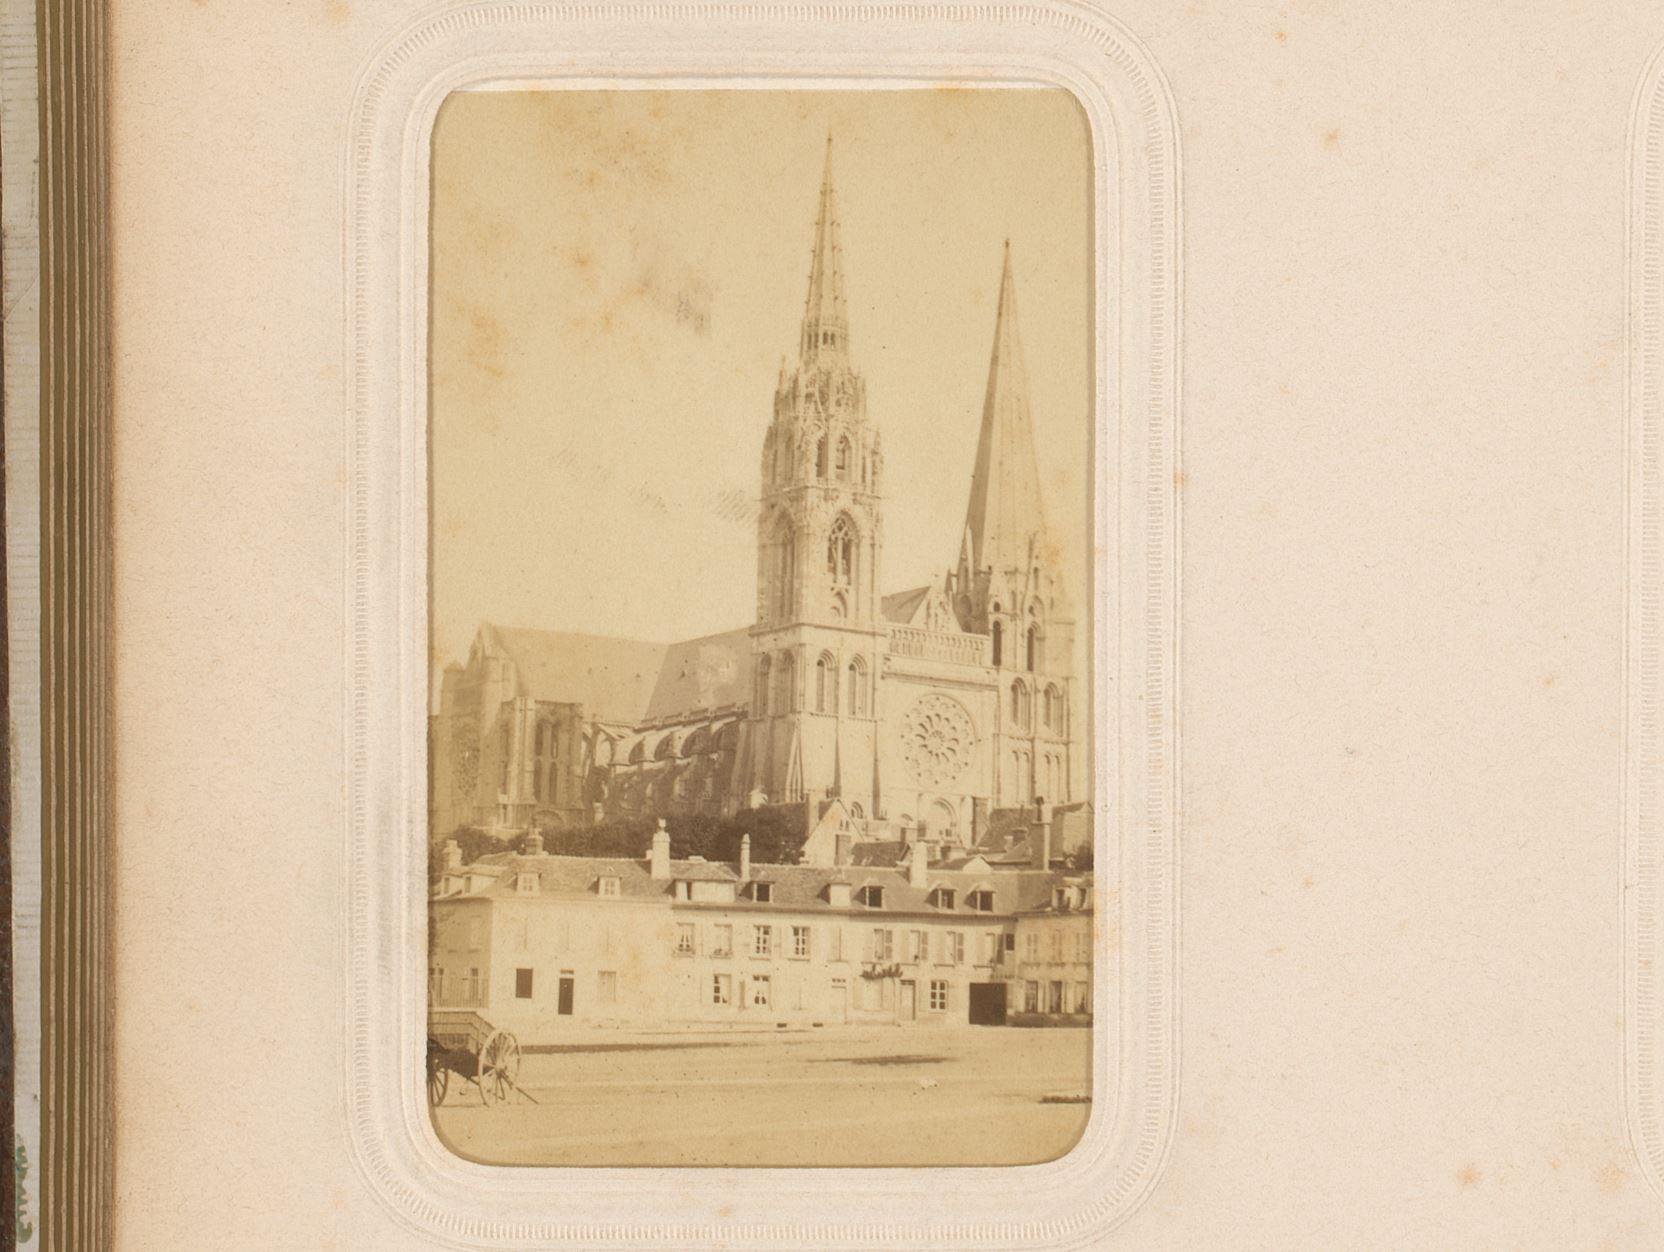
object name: album leaf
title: Gezicht op een kerk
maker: Anonymous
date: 1859-1867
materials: cardboard, photographic support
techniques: albumen print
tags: church (exterior)